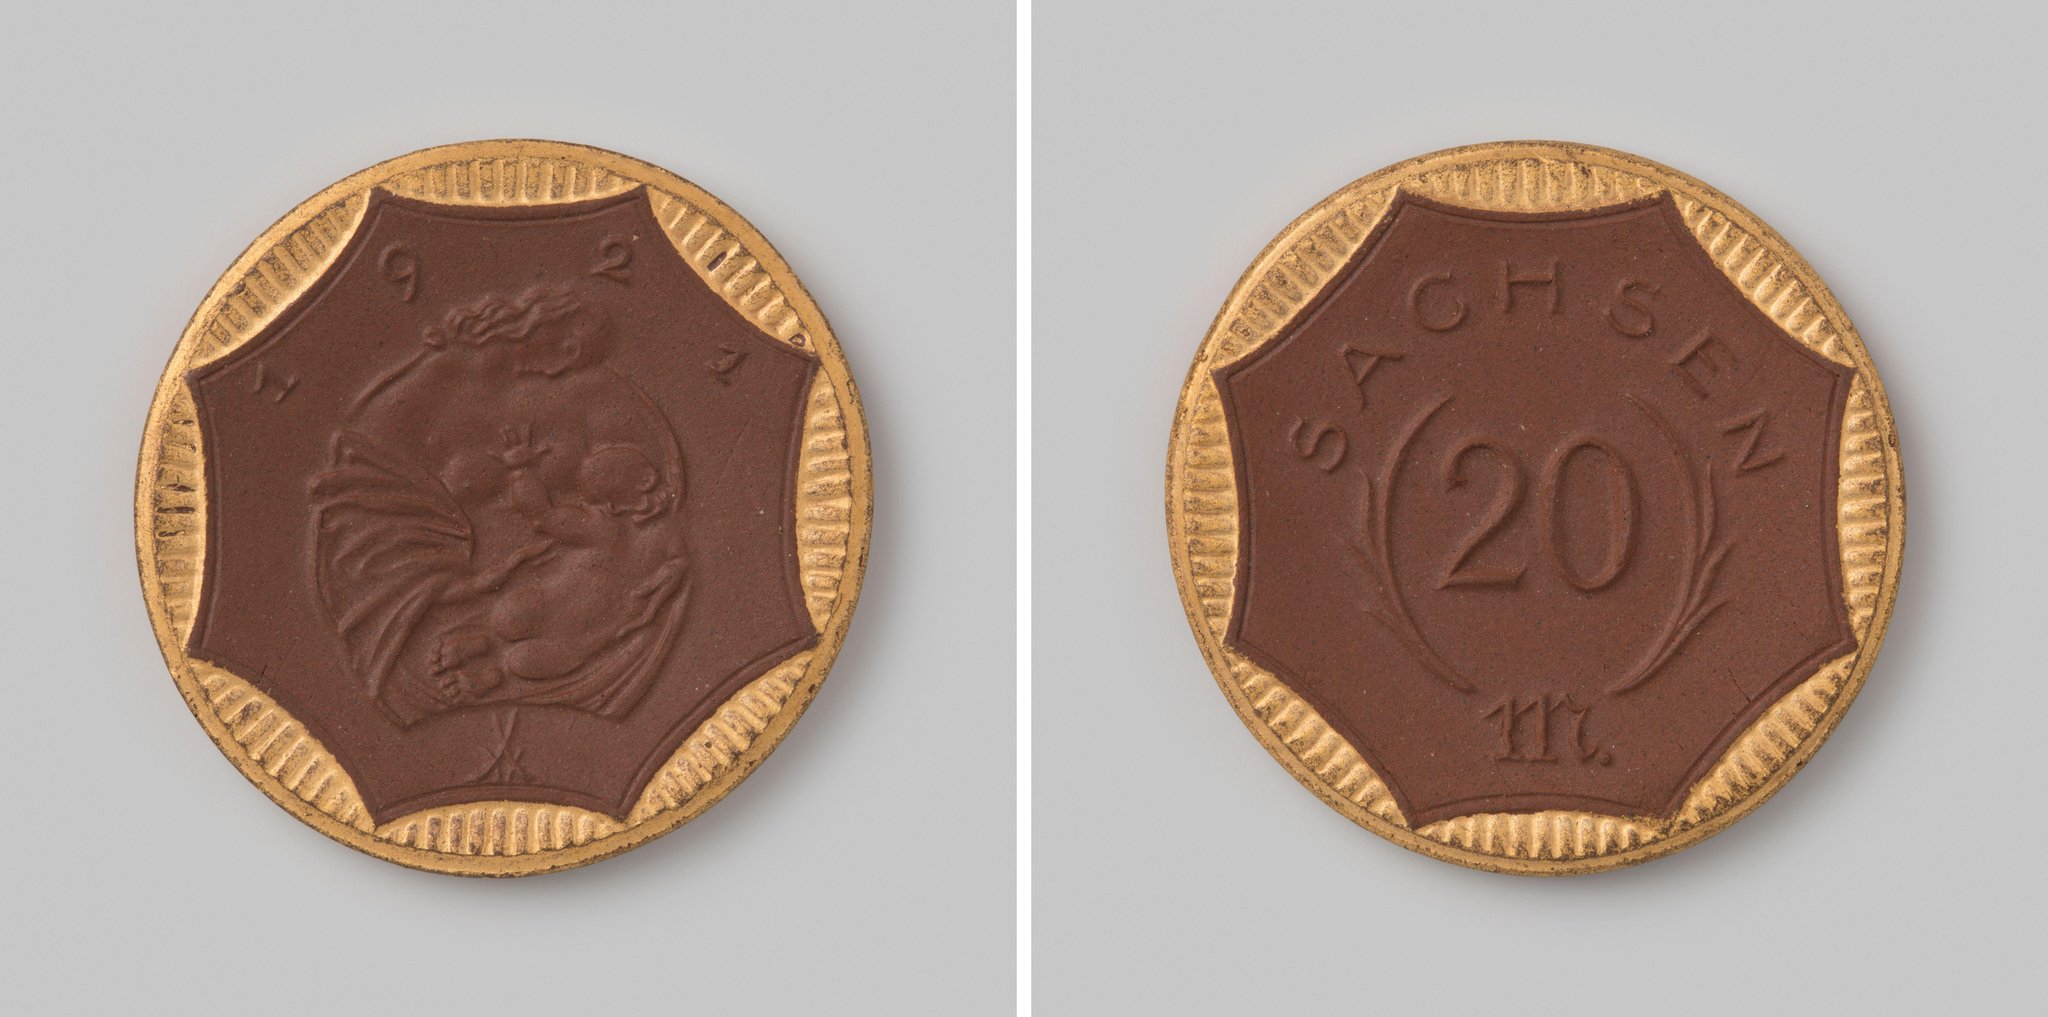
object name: coin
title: 20 mark uit Duitsland, Saksen, 1921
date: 1921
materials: porcelain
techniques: casting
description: Porseleinen pseudomunt met vergulde rand. Voorzijde: moeder met kind, waarboven jaartal. Keerzijde: binnen versiering waarde-aanduiding in twee regels. Daaromheen land-aanduiding. Gladde rand.